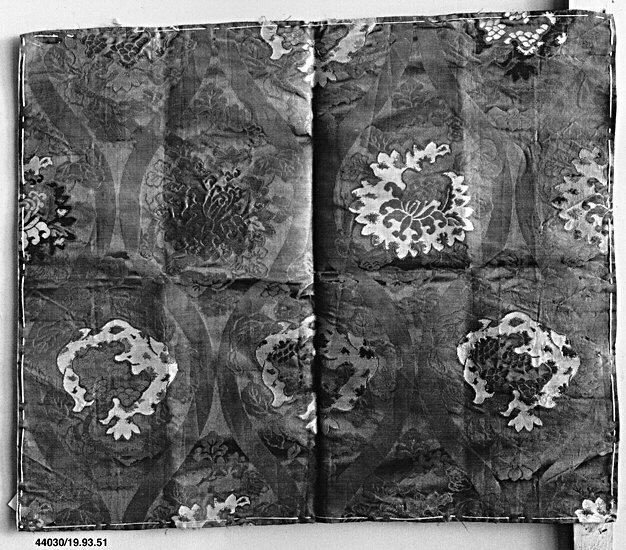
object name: altar cloth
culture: japanese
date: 1625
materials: metal thread, silk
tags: flowers